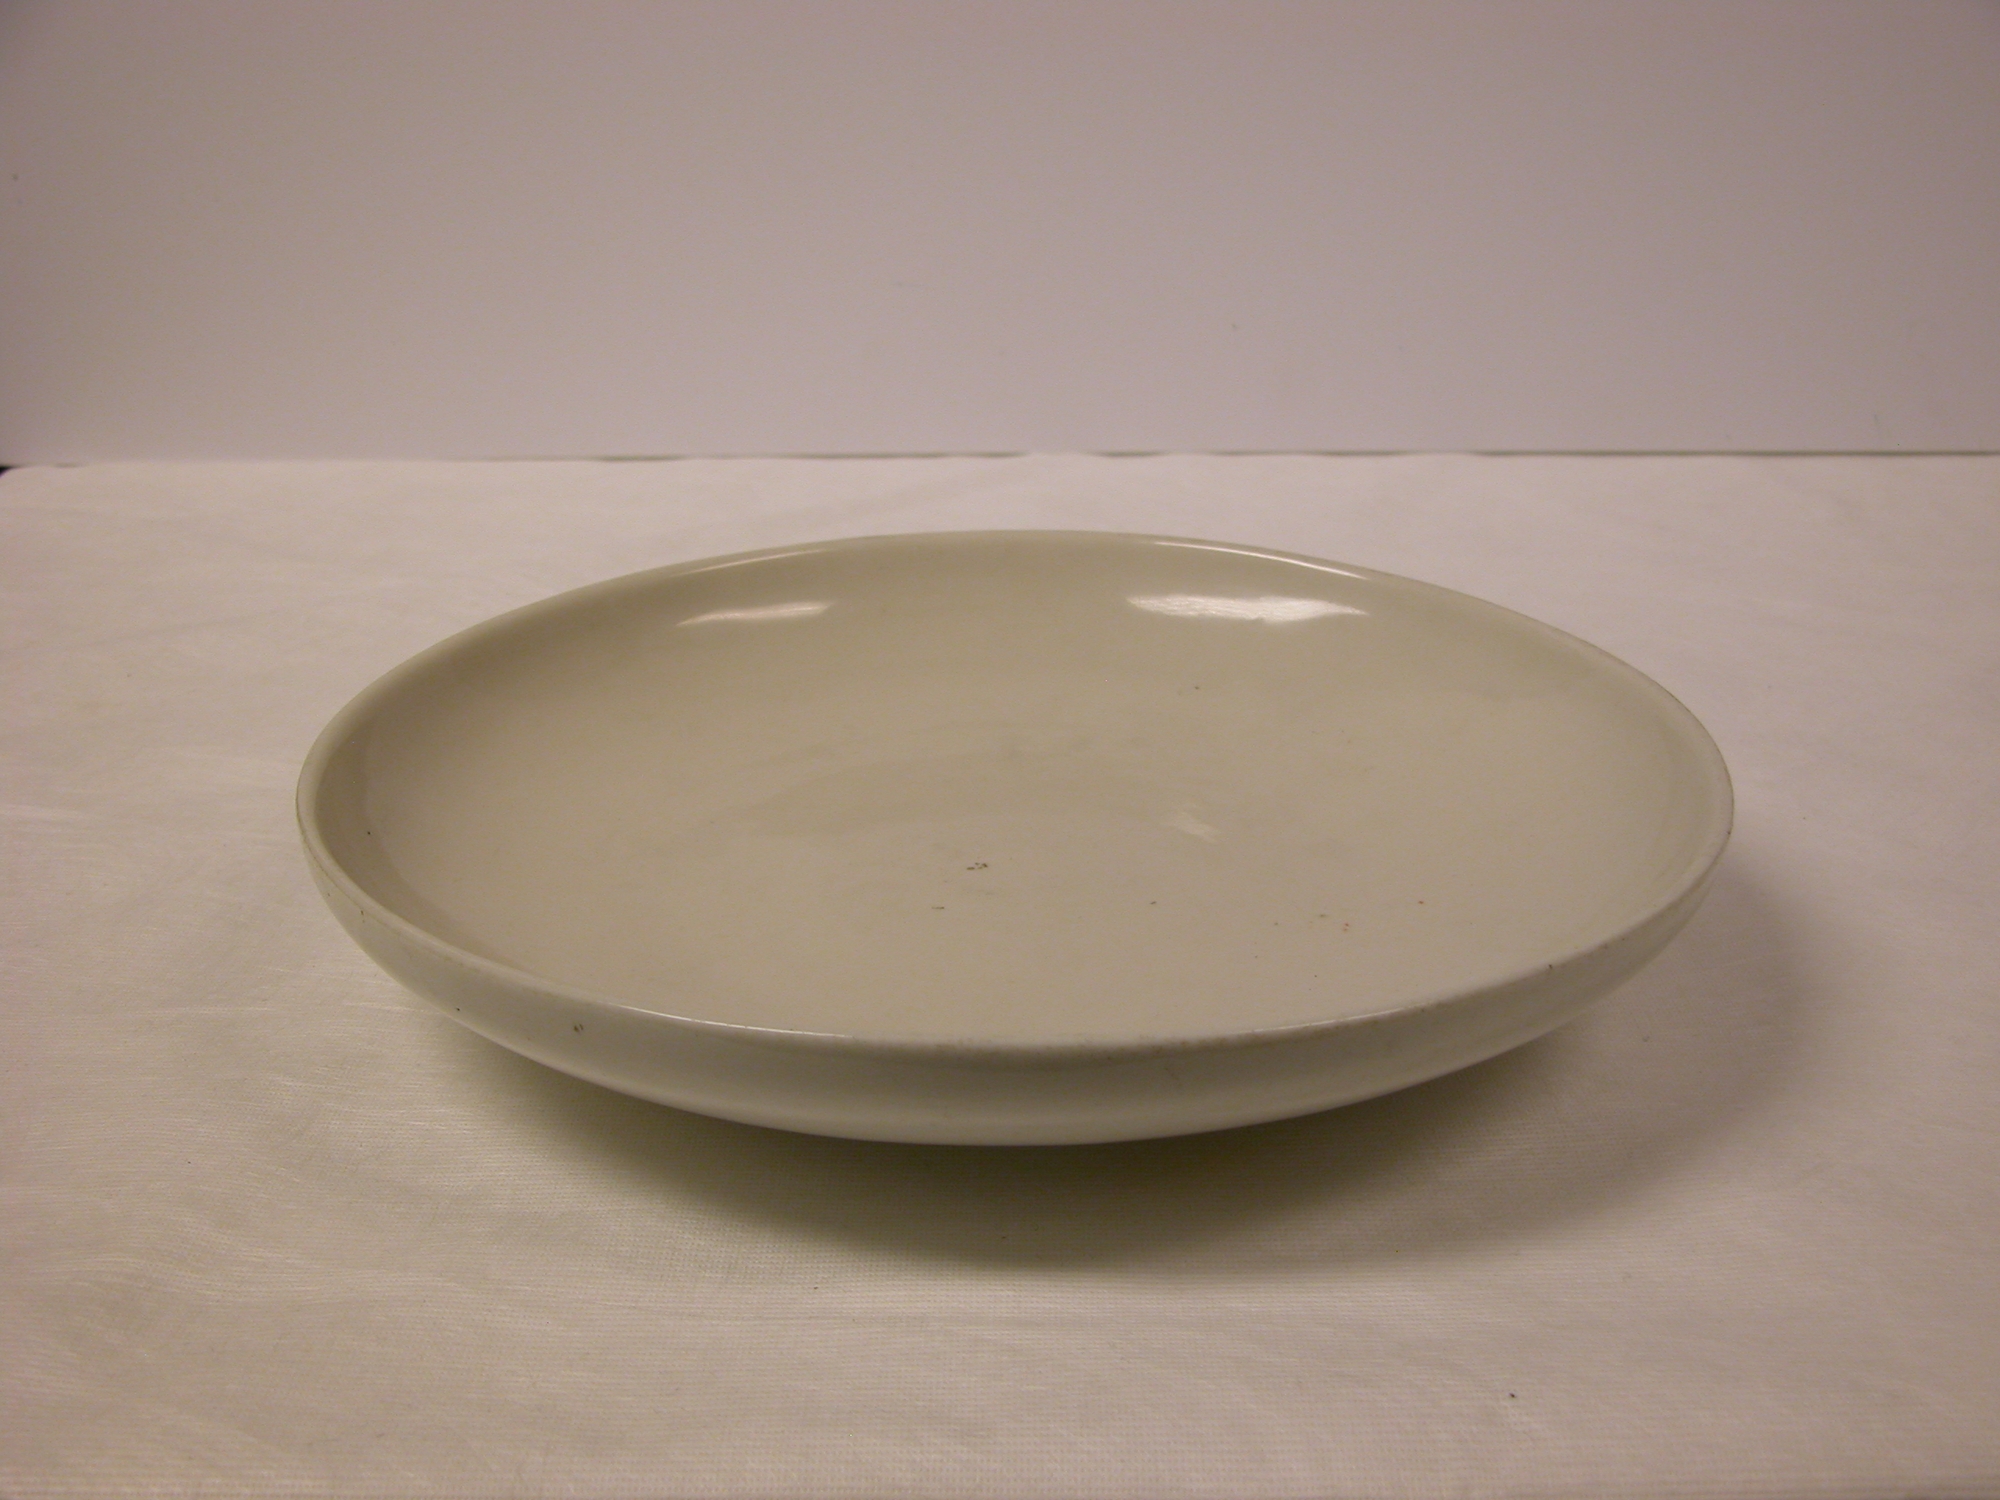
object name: dish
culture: chinese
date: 1601-1700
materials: porcelain